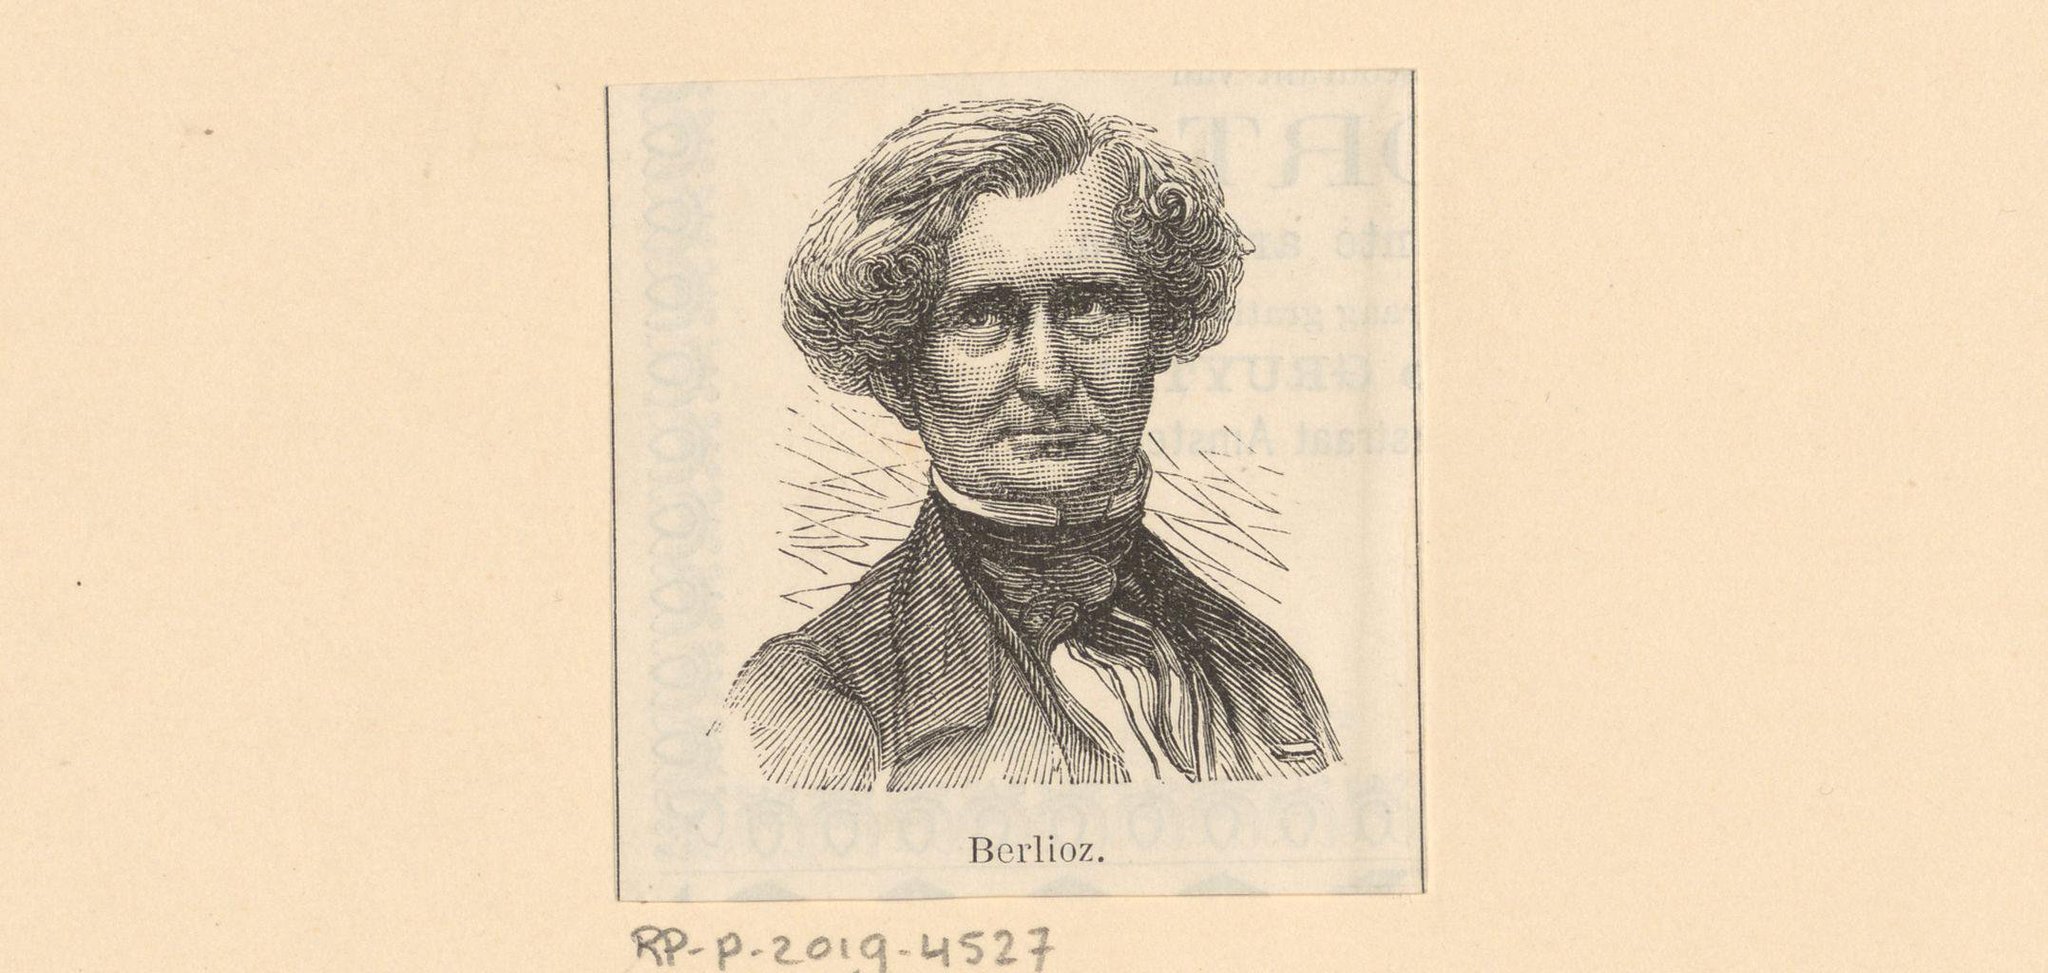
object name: print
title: Portret van Hector Berlioz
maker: Anonymous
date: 1850-1899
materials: paper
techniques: letterpress printing, engraving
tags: paris, hector berlioz, historical persons, portrait of composer